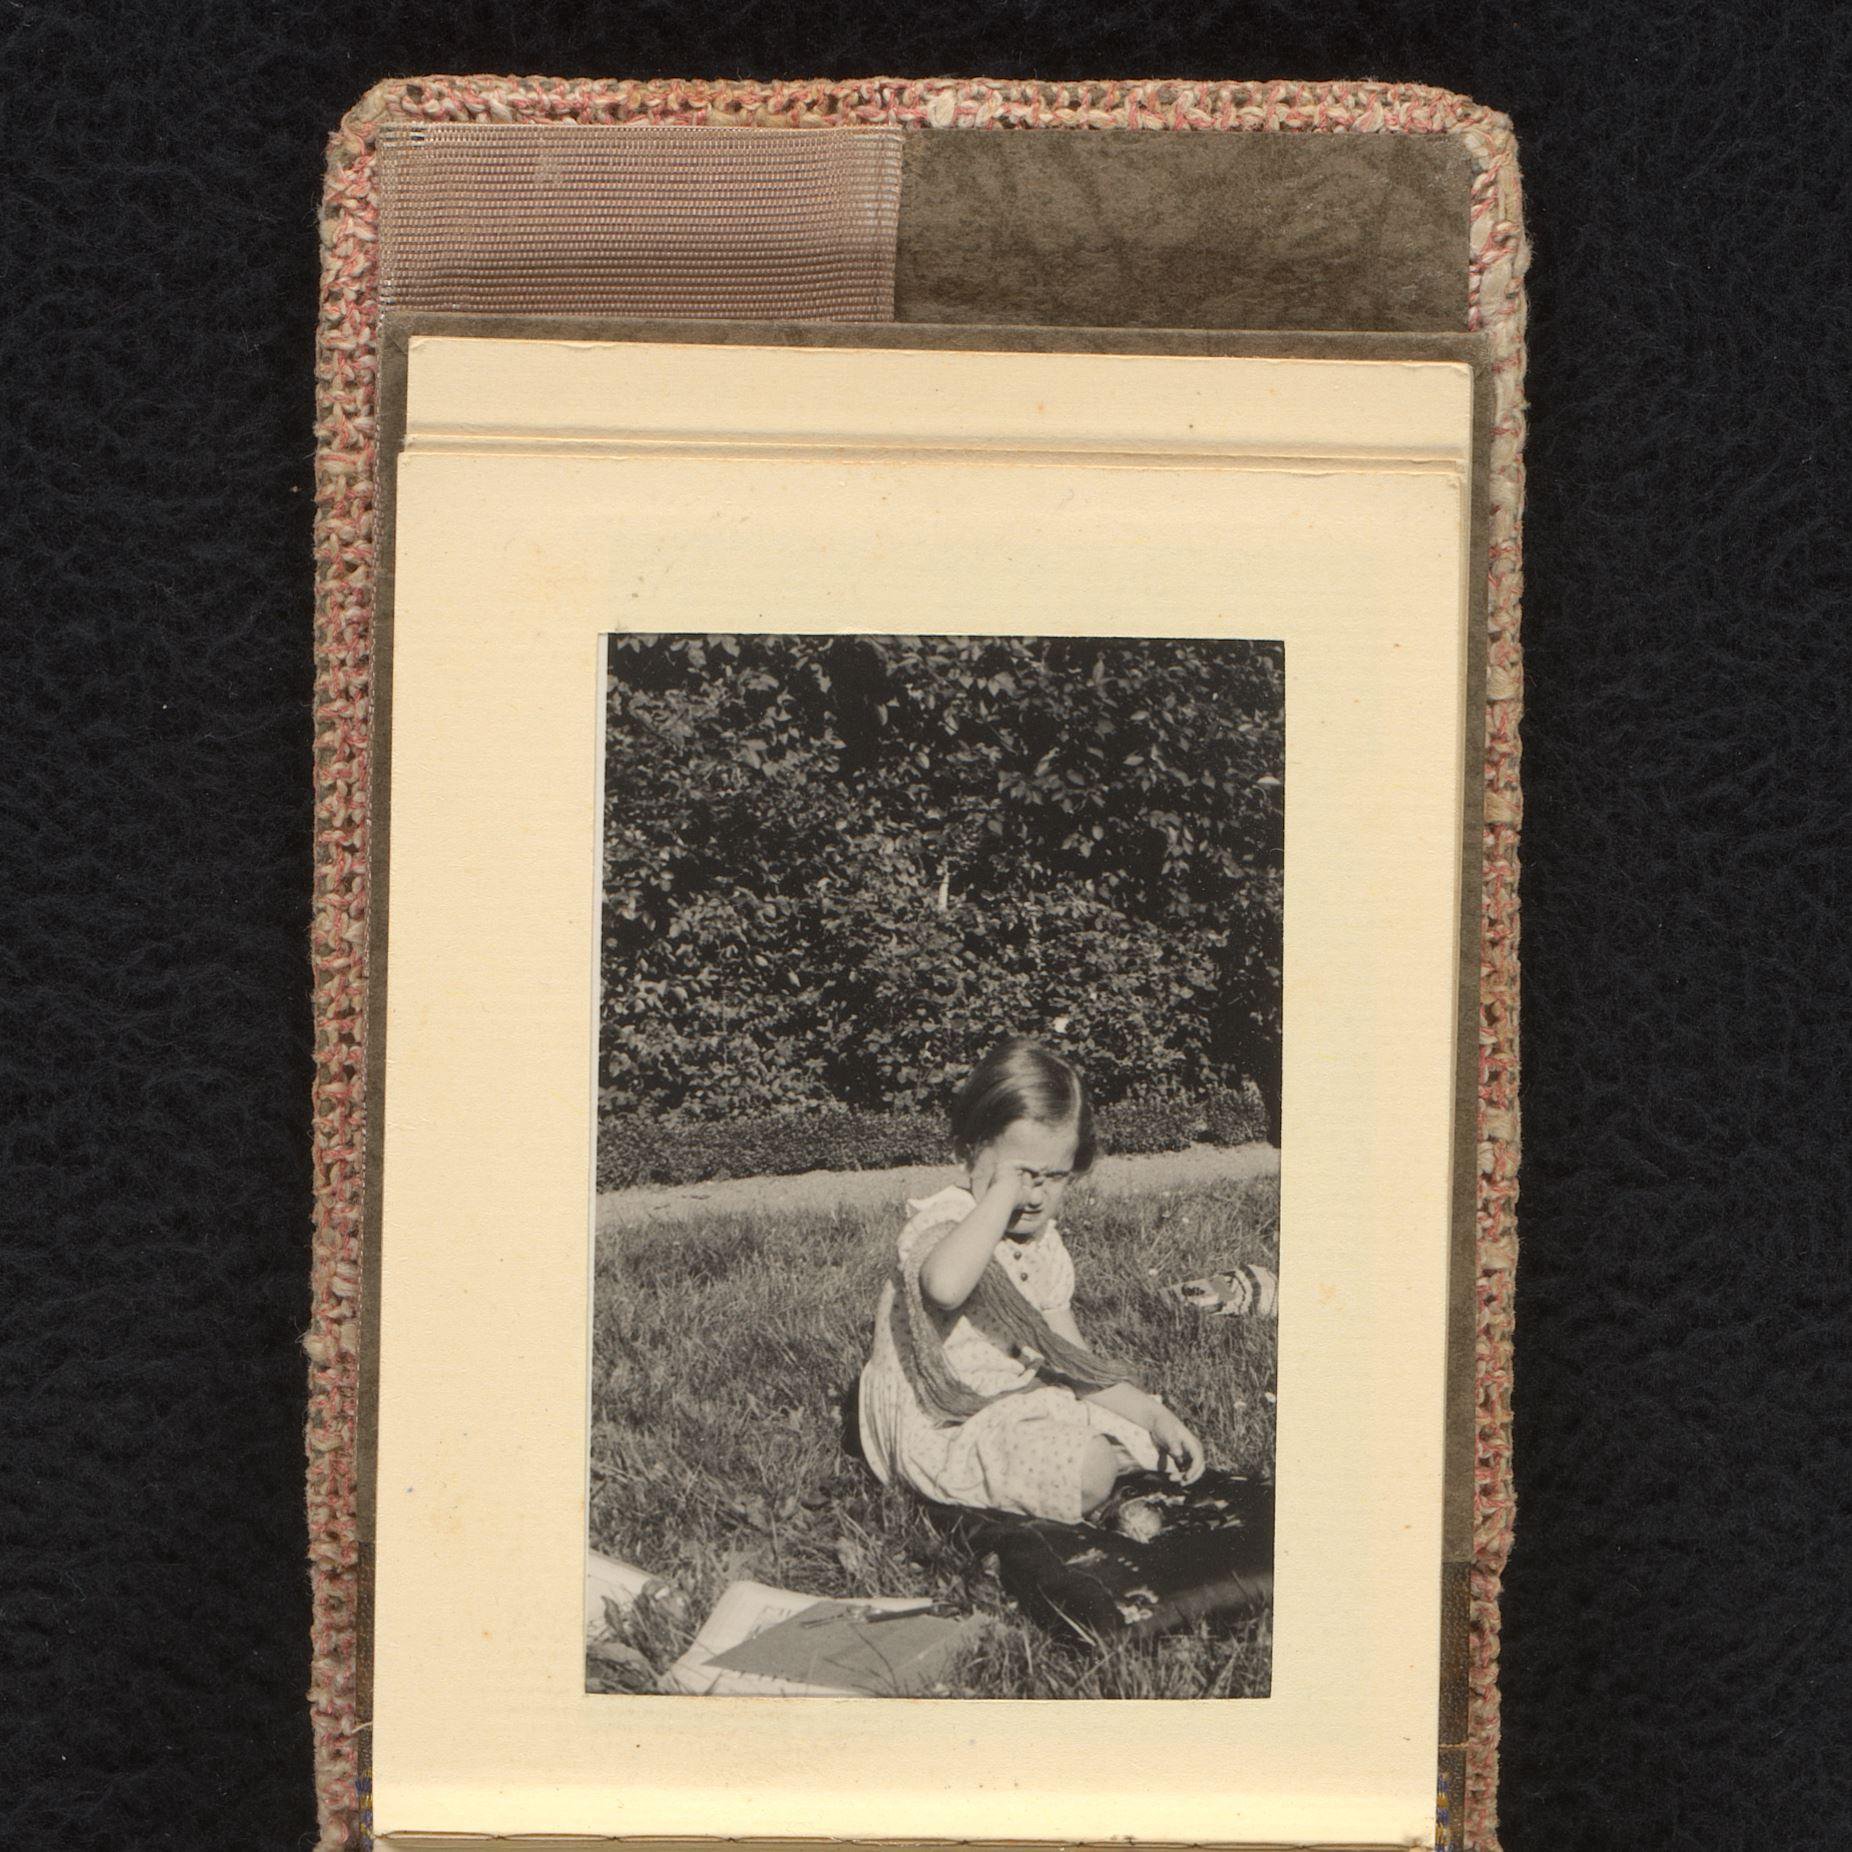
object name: album leaf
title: Isabel Wachenheimer in de tuin, juli-augustus 1933, Hamburg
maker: else wachenheimer-moos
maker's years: 1895-1944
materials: paper, photographic support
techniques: gelatin silver print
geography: hamburg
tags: leiden, isabel wachenheimer-elon, the family travelling, on holiday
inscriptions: date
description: Albumblad bevat een foto van Isabel Wachenheimer. Onderdeel van het fotoalbum Hamburg zomer 1933.